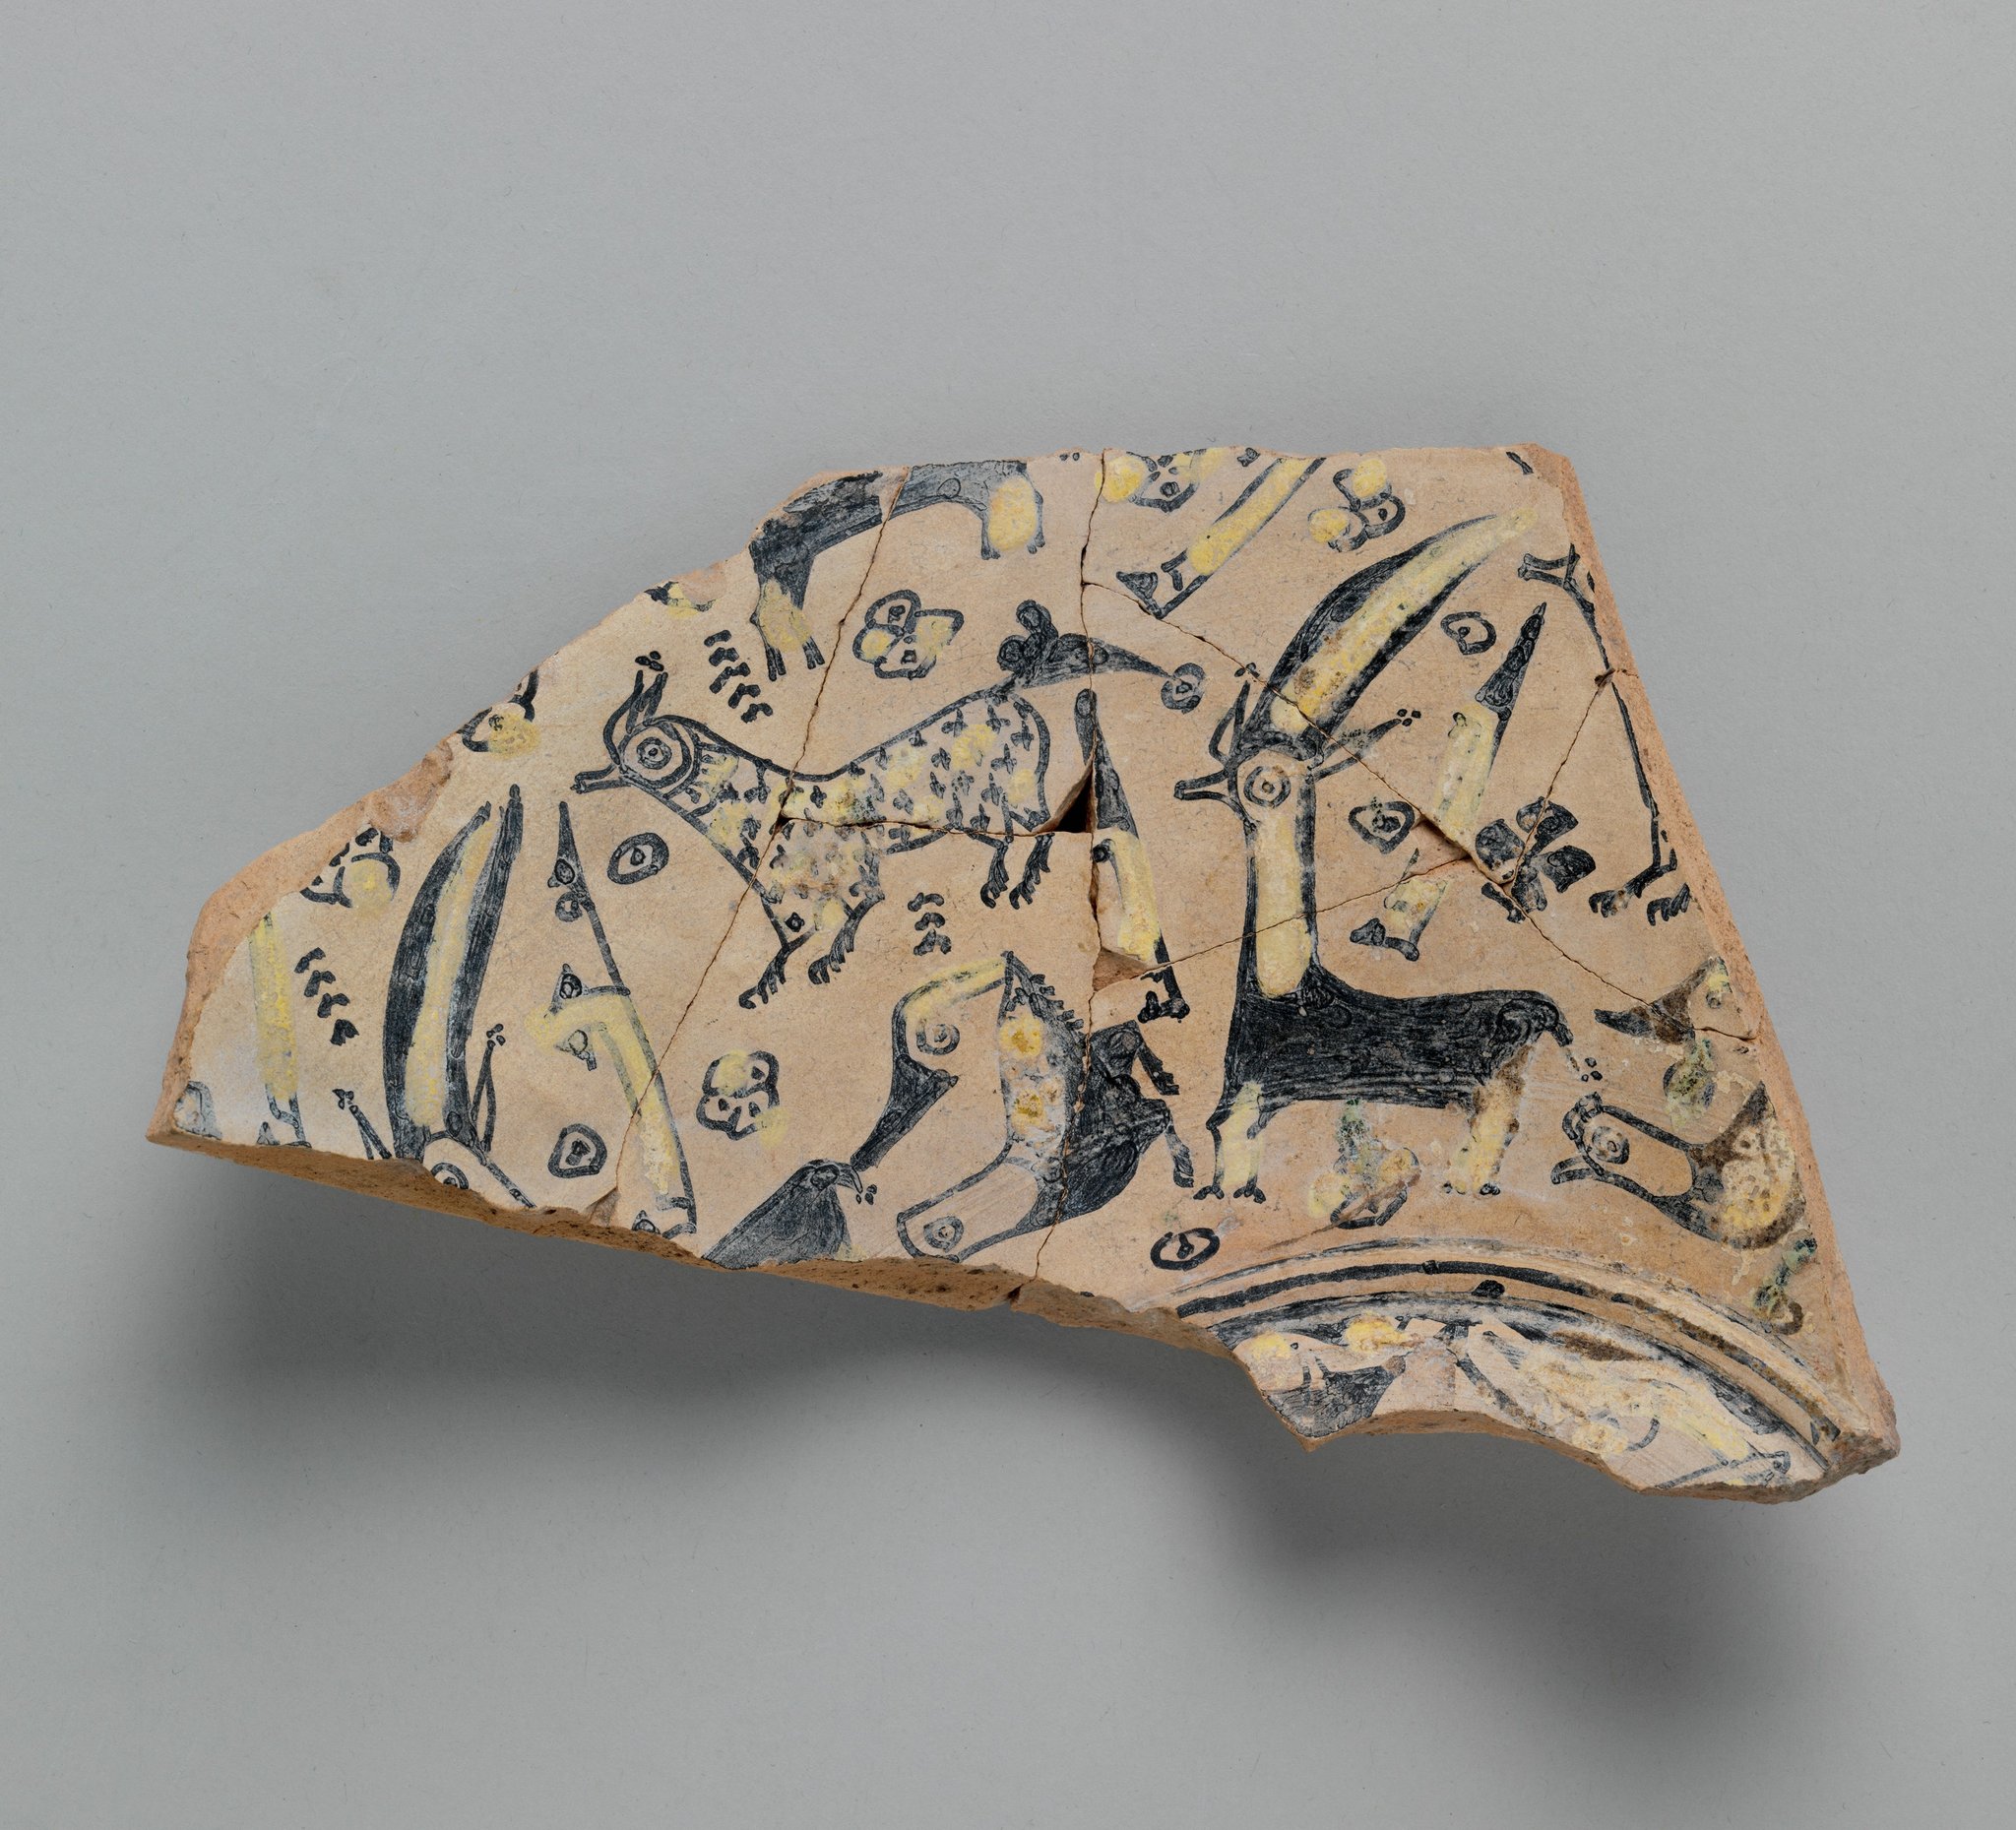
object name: fragment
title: Buff Ware Fragment with Animal Decoration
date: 801-900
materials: earthenware, glaze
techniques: polychrome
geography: iran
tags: animals